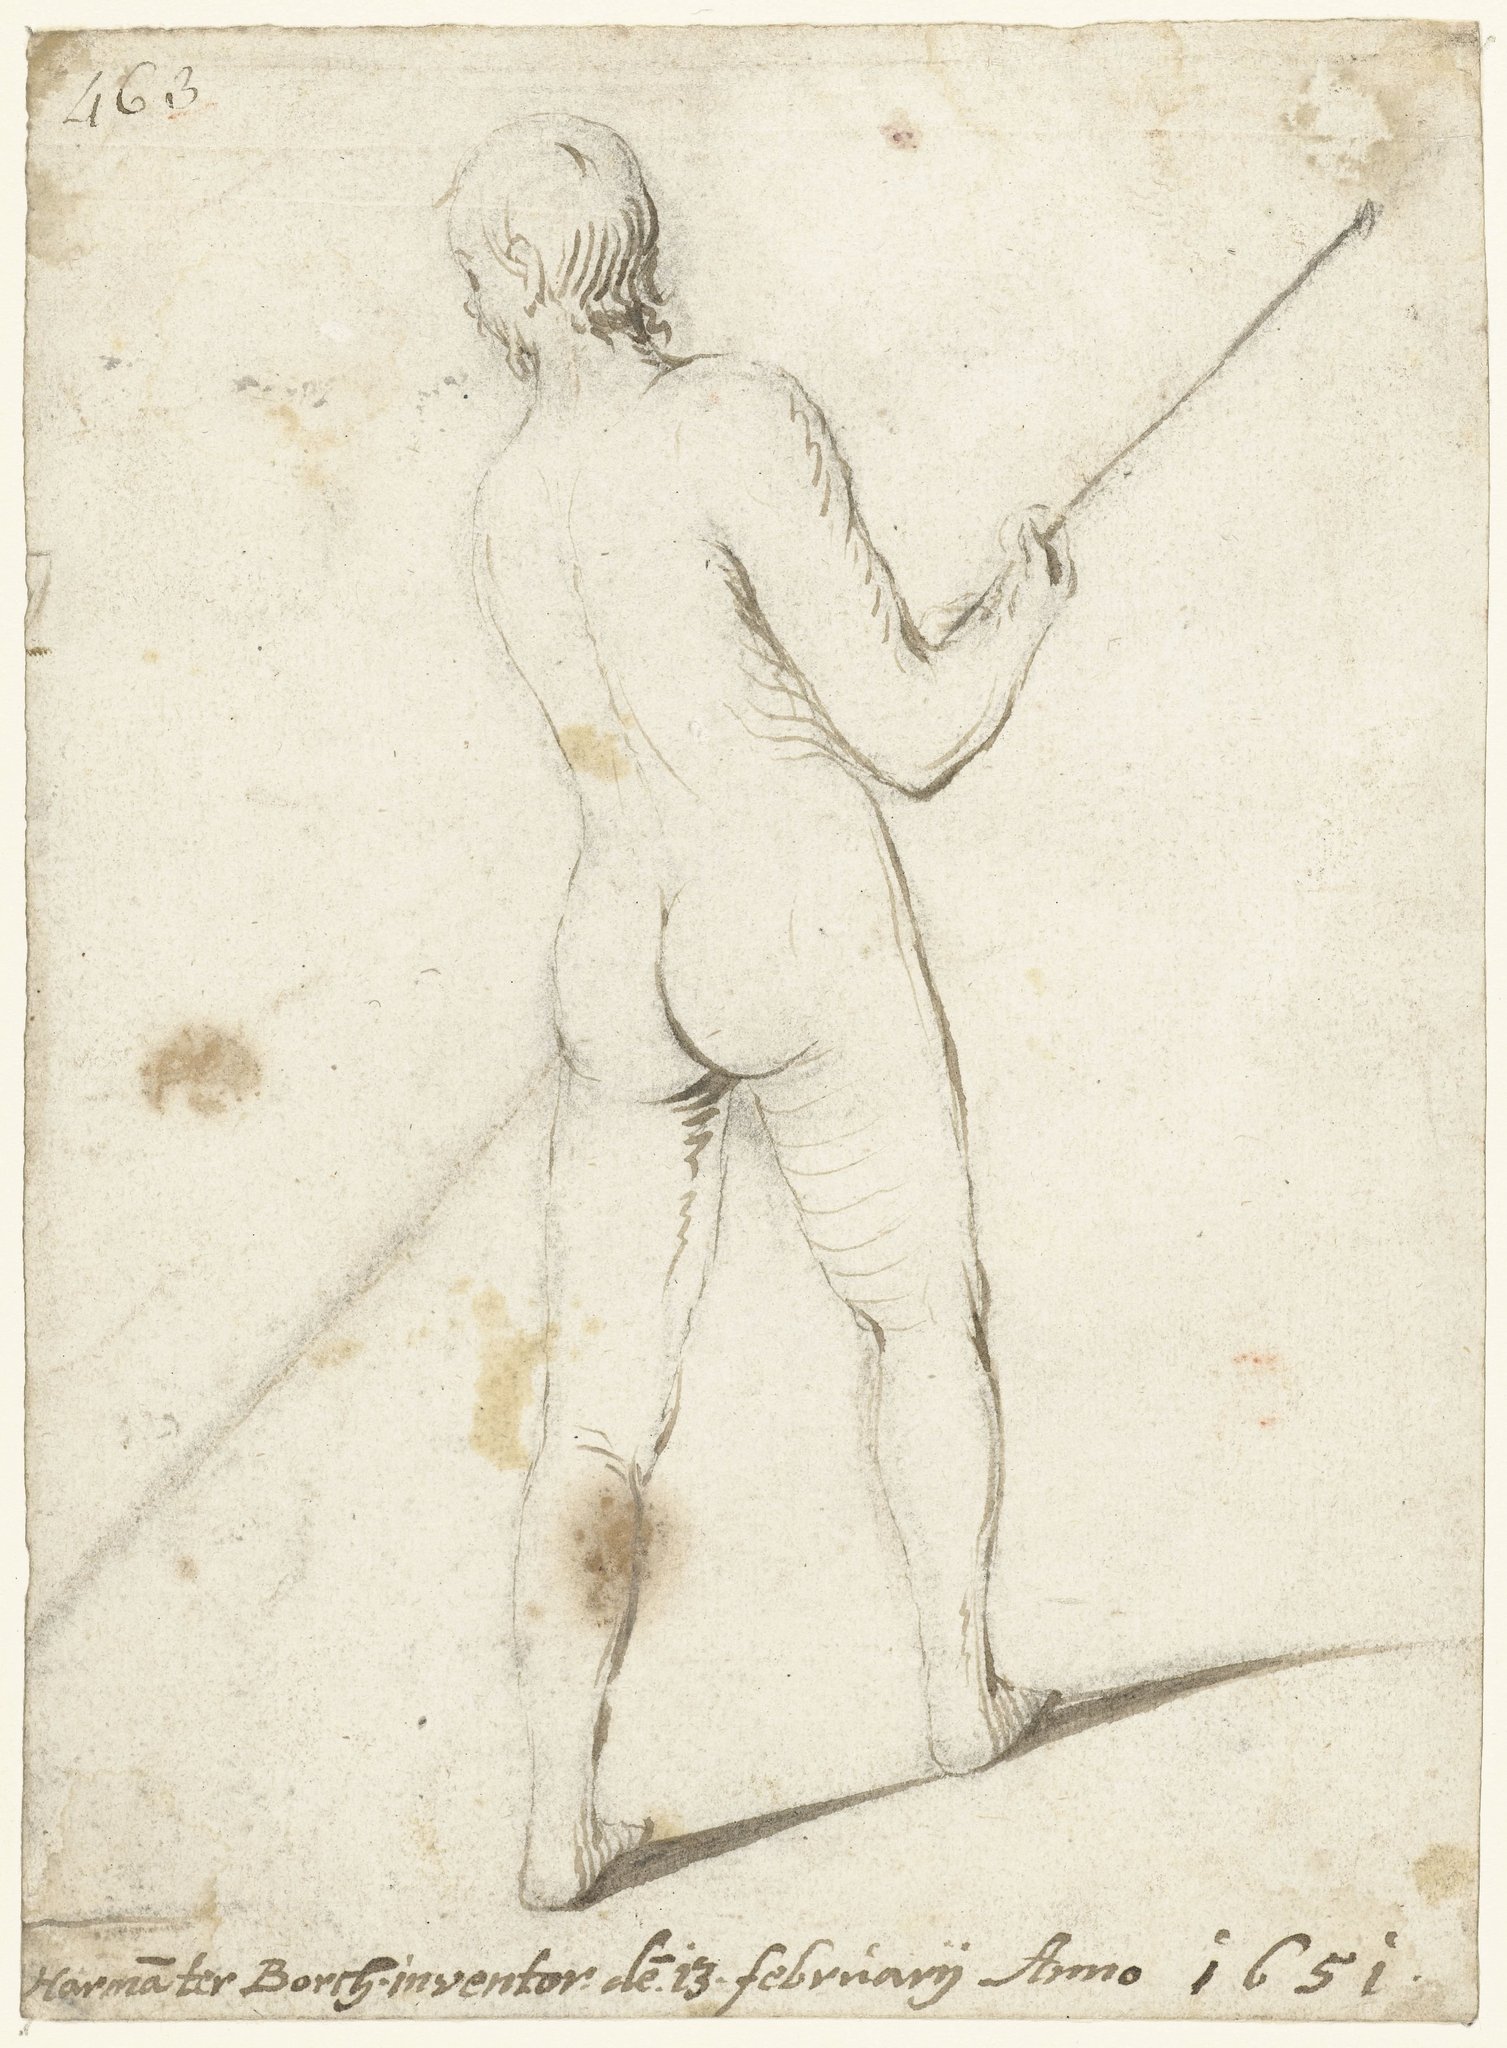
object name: drawing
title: Naakte man met lange stok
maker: harmen ter borch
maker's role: draughtsman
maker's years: 1638-1677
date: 1651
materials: chalk, ink, paper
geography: zwolle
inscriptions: annotation: ‘Harma[n] ter Borch. inventor. de[n]. 13. februarij Anno 1651’